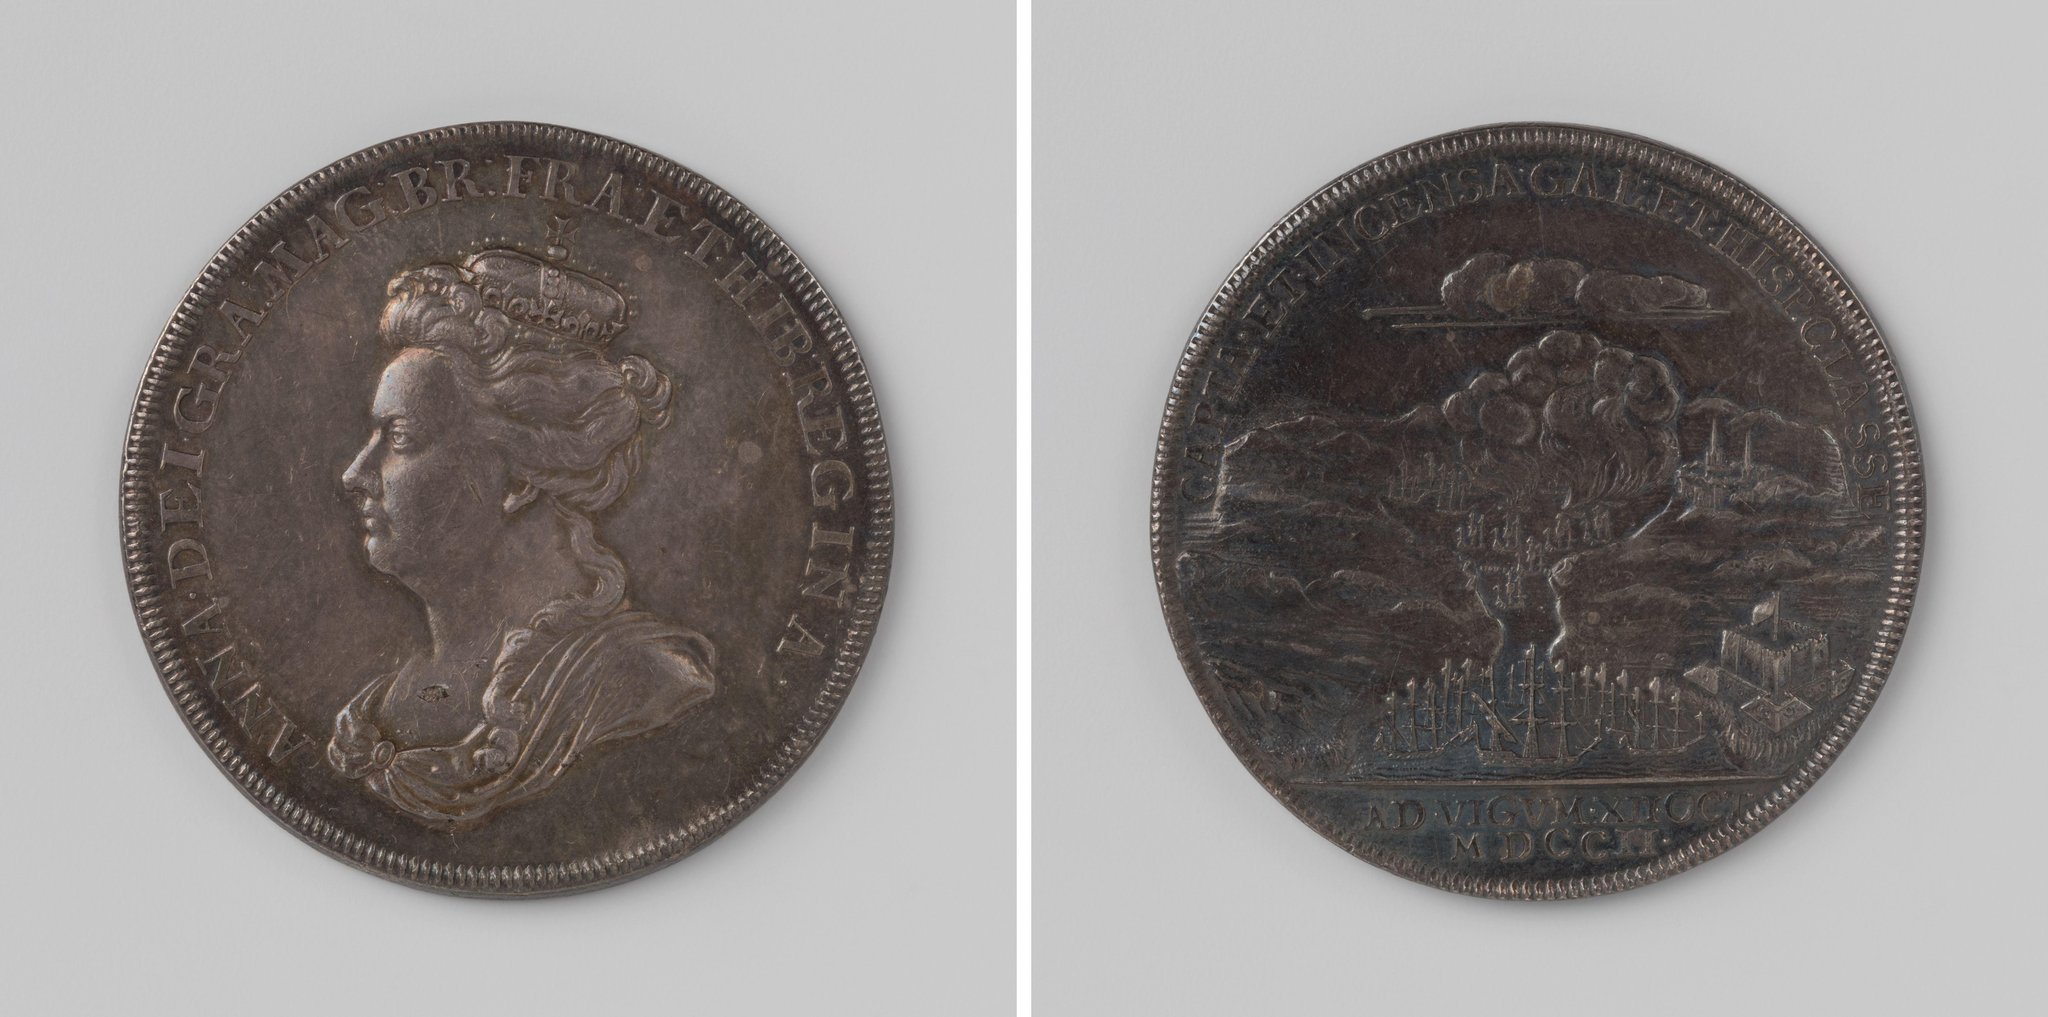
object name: history medal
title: Zeeslag bij Vigo (Vigos): het verbranden van de Franse en Spaanse vloot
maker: john croker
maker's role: die cutter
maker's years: 1670-1741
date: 1702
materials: silver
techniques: striking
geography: london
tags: london, anna stuart (koningin van engeland en schotland)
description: Zilveren penning. Voorzijde: borststuk vrouw met kroon binnen omschrift. Keerzijde: gezicht op baai van Vigo met brandende schepen; Engels-Nederlandse vloot liggend aan monding van baai binnen omschrift, boven opschrift